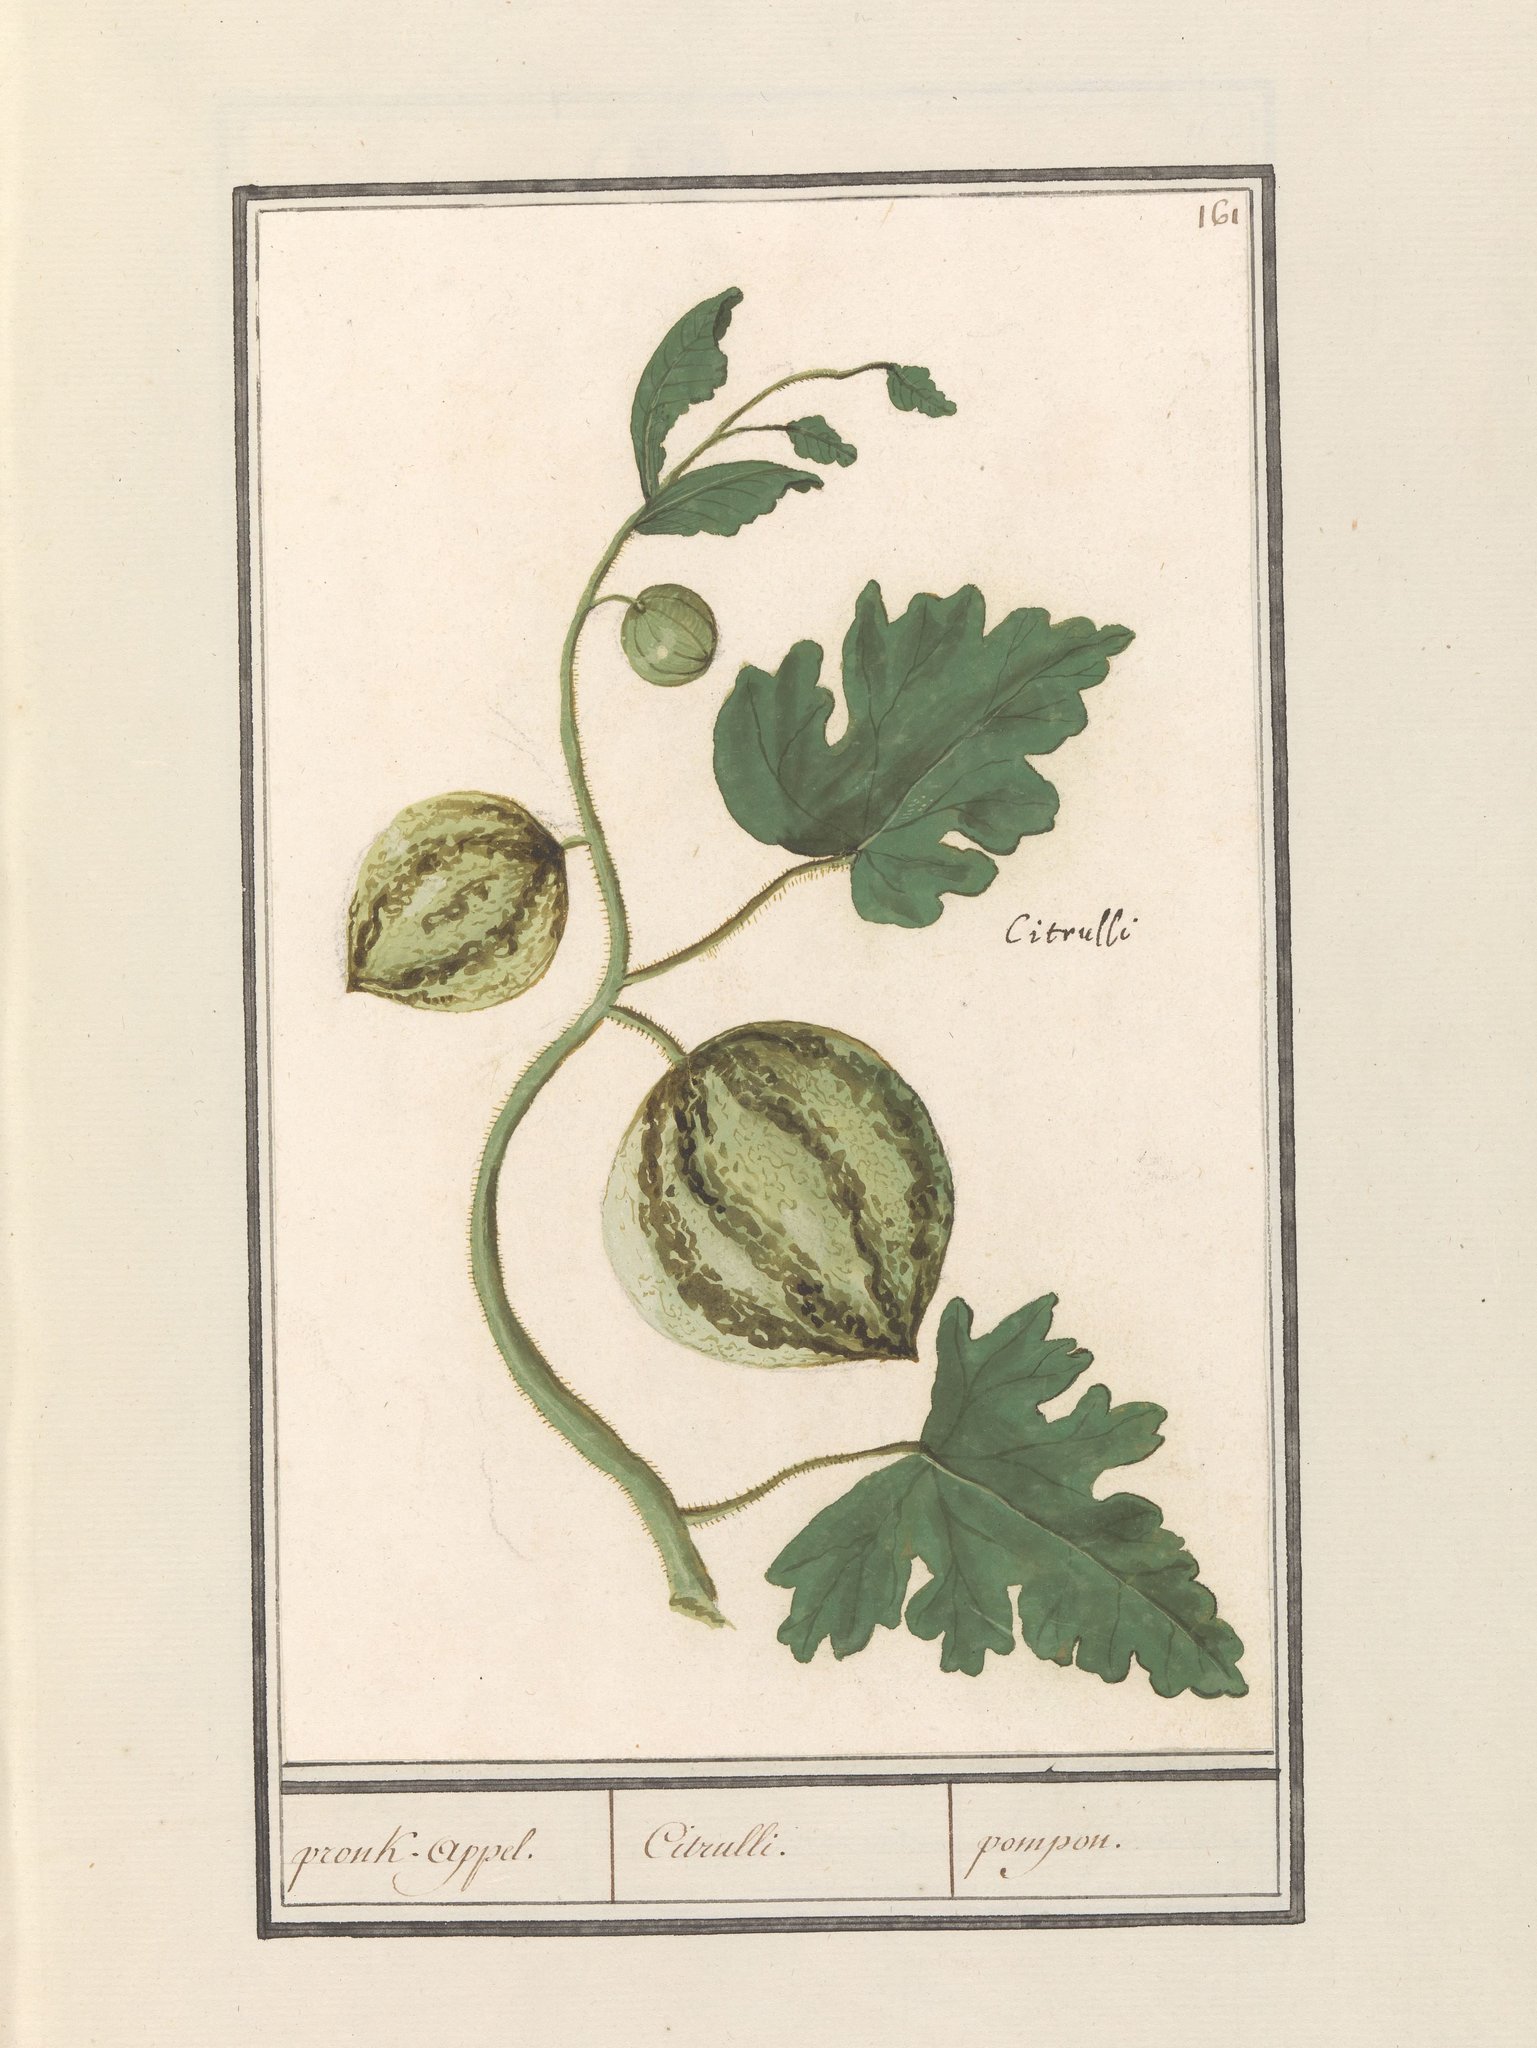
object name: drawing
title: Watermelon (Citrullus vulgaris)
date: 1596-1610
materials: chalk, paint, ink, paper, watercolor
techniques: brush, pen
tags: fruits: watermelon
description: Without the representation of the watermelon’s red flesh, this fruit is difficult to identify. The names in the box also provide little clarification. The term ‘pronk appel’ refers to an elongated or spherical, decorative fruit; a pumpkin or gourd, and not strictly a (water)melon. The three growth stages shown demonstrate that the fruit becomes large and heavy. In the case of watermelons, this can sometimes amount to twelve kilograms.